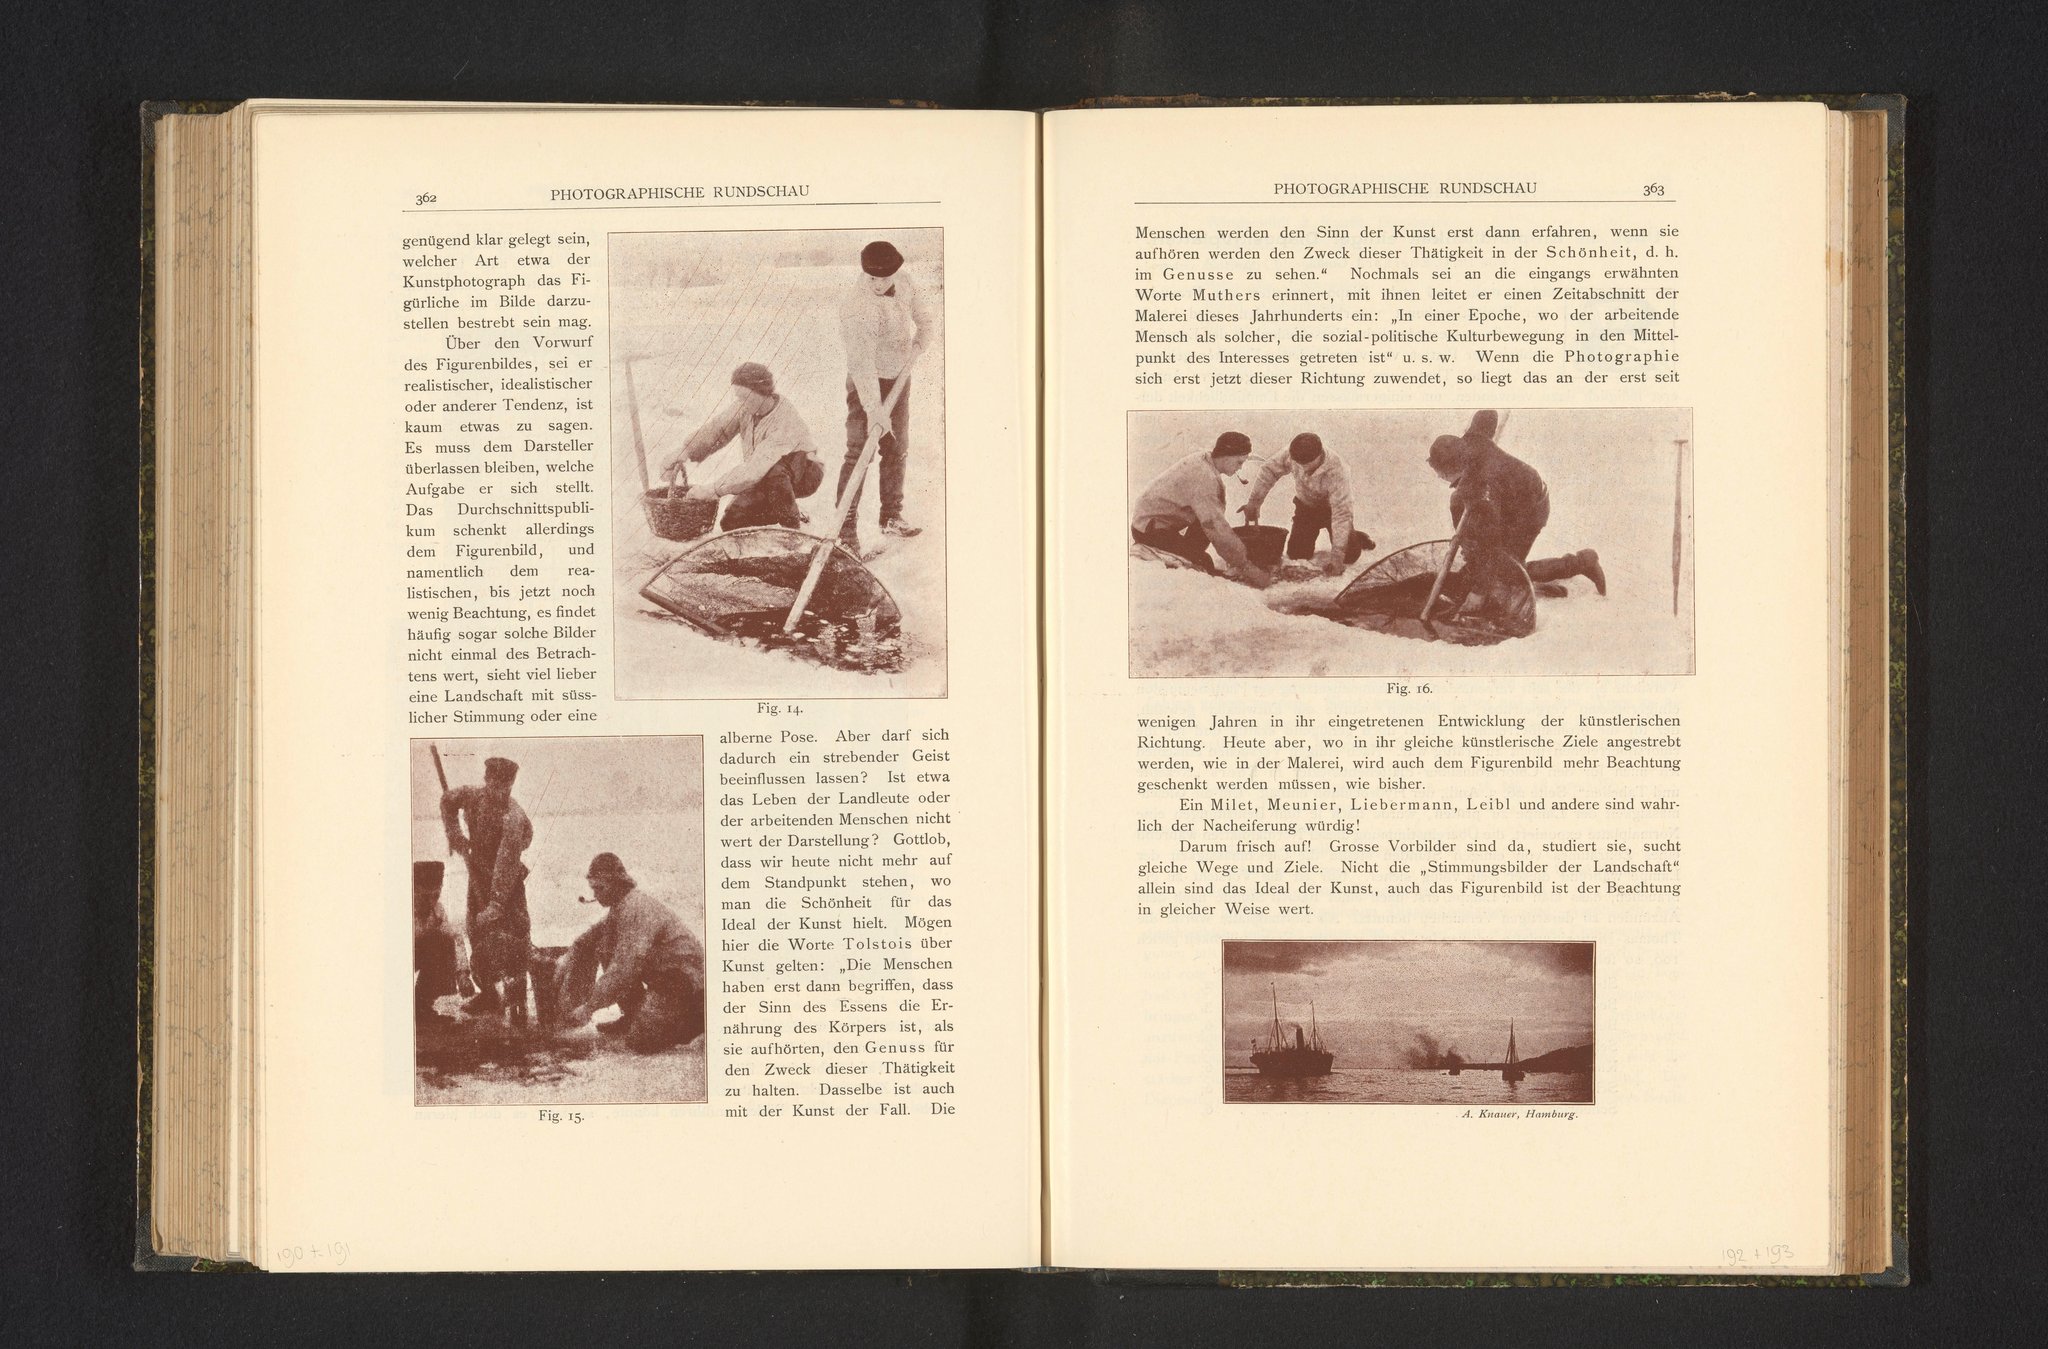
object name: photomechanical print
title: Drie onbekende mannen die ijsvissen en pijp roken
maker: Anonymous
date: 1893-1898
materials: paper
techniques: autotype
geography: berlin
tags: snow, ice ~ state of water, fisherman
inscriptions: monogram: ‘MR/ &Co’